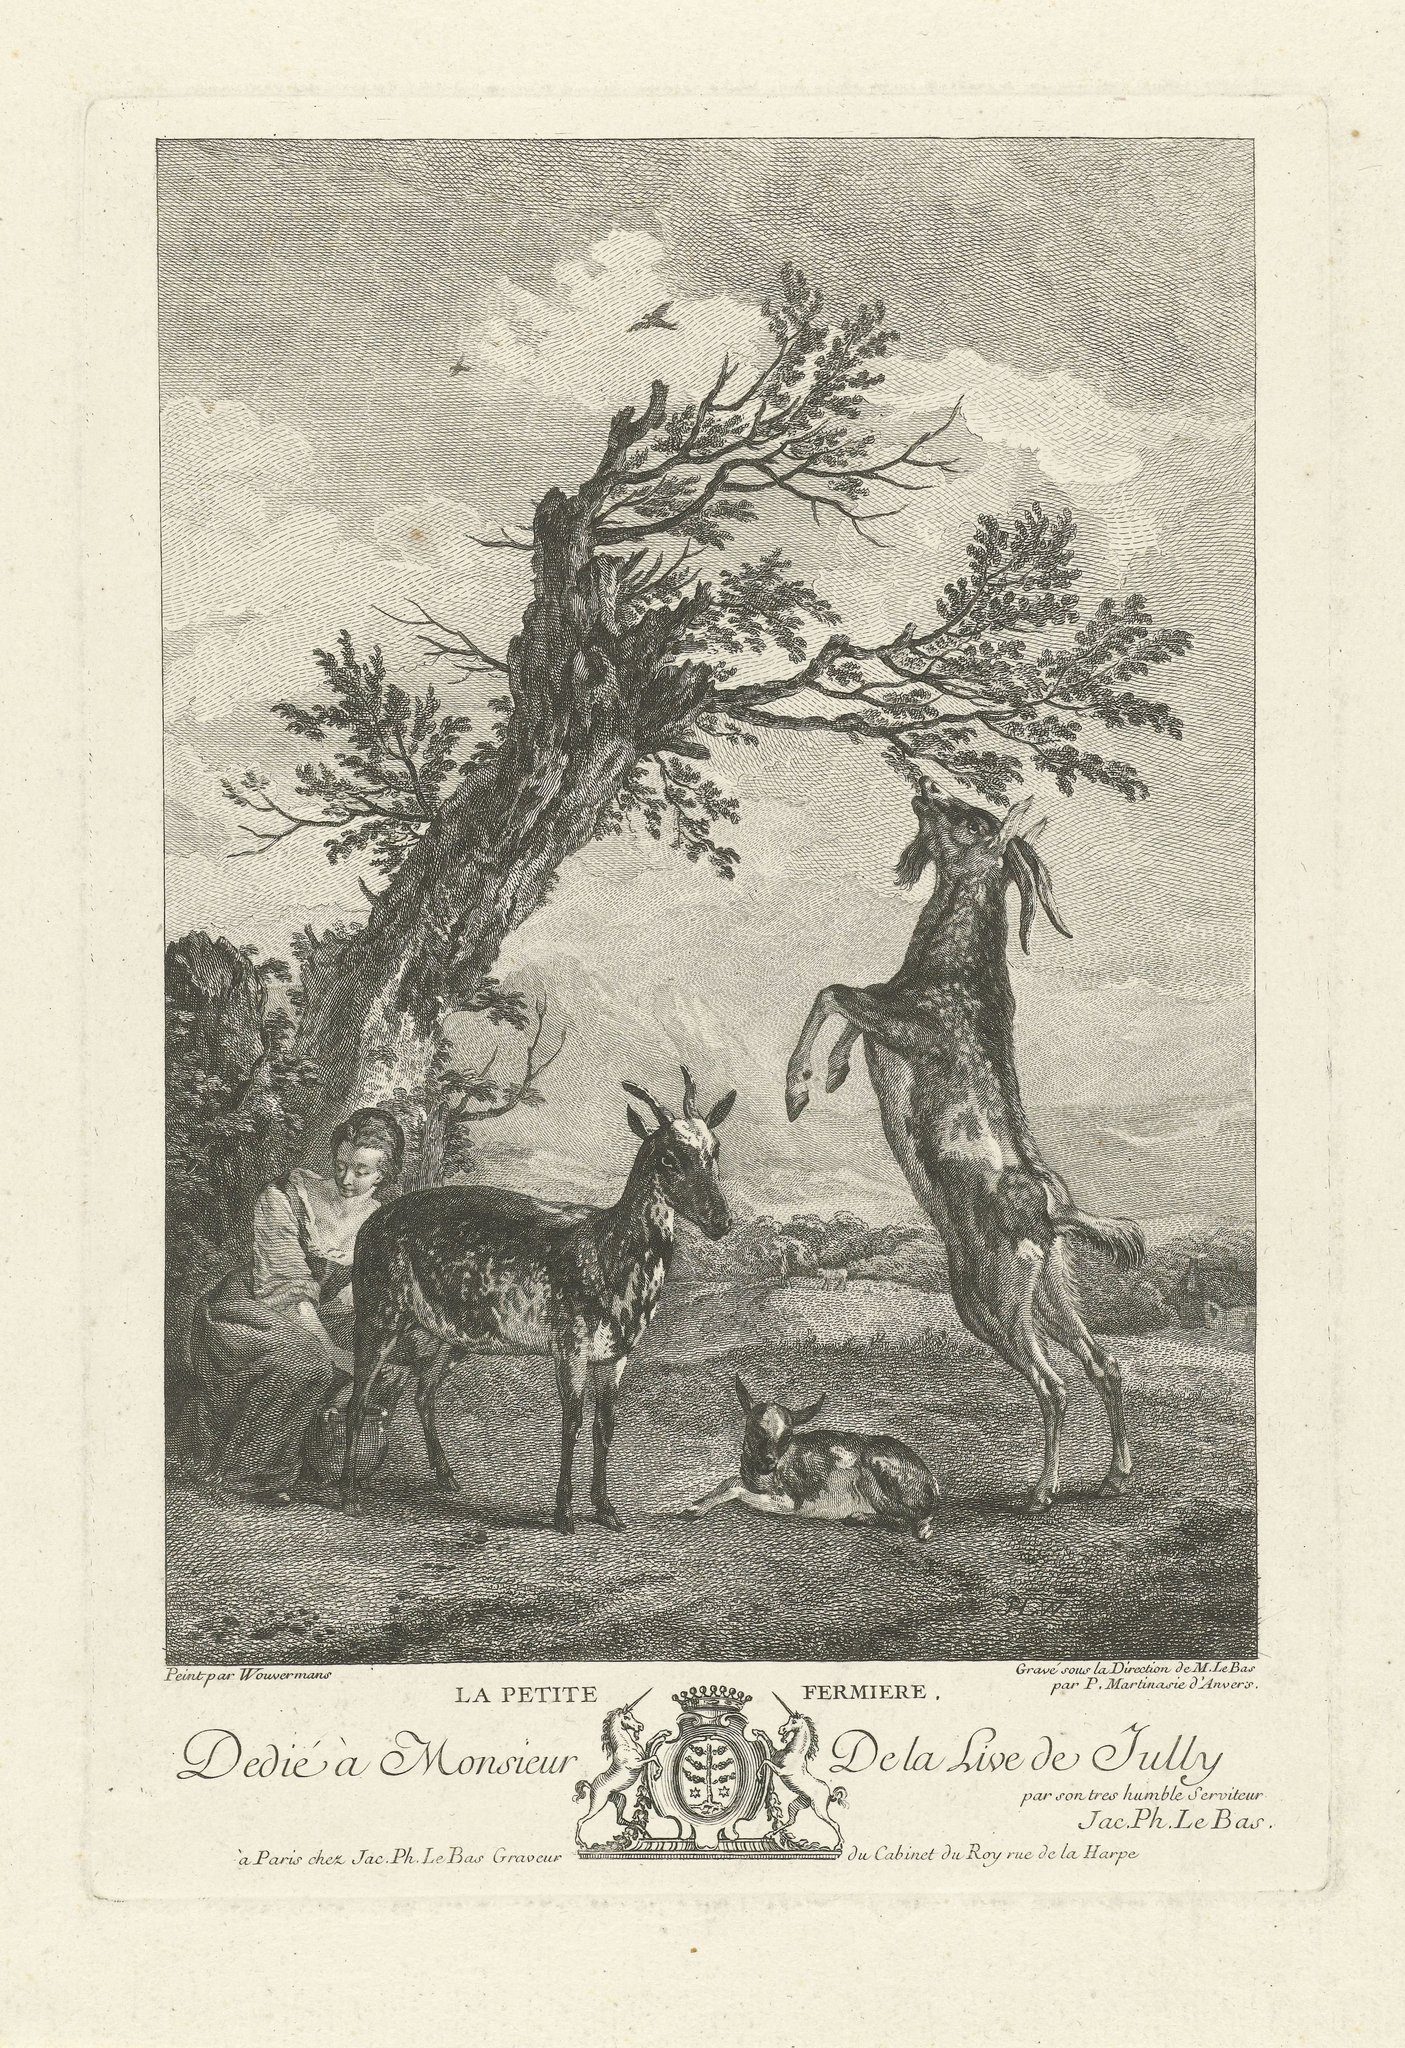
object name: print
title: La Petite Fermiere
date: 1739-1789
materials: paper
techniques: etching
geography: antwerp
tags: he-goat, billy-goat, kid (goat), she-goat, nanny-goat, milking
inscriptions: collector's mark: Lugt 2228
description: Een jong geitje ligt op de grond in een landschap, rechts reikt een geit naar bladeren in een boom en links melkt een vrouw een andere geit.